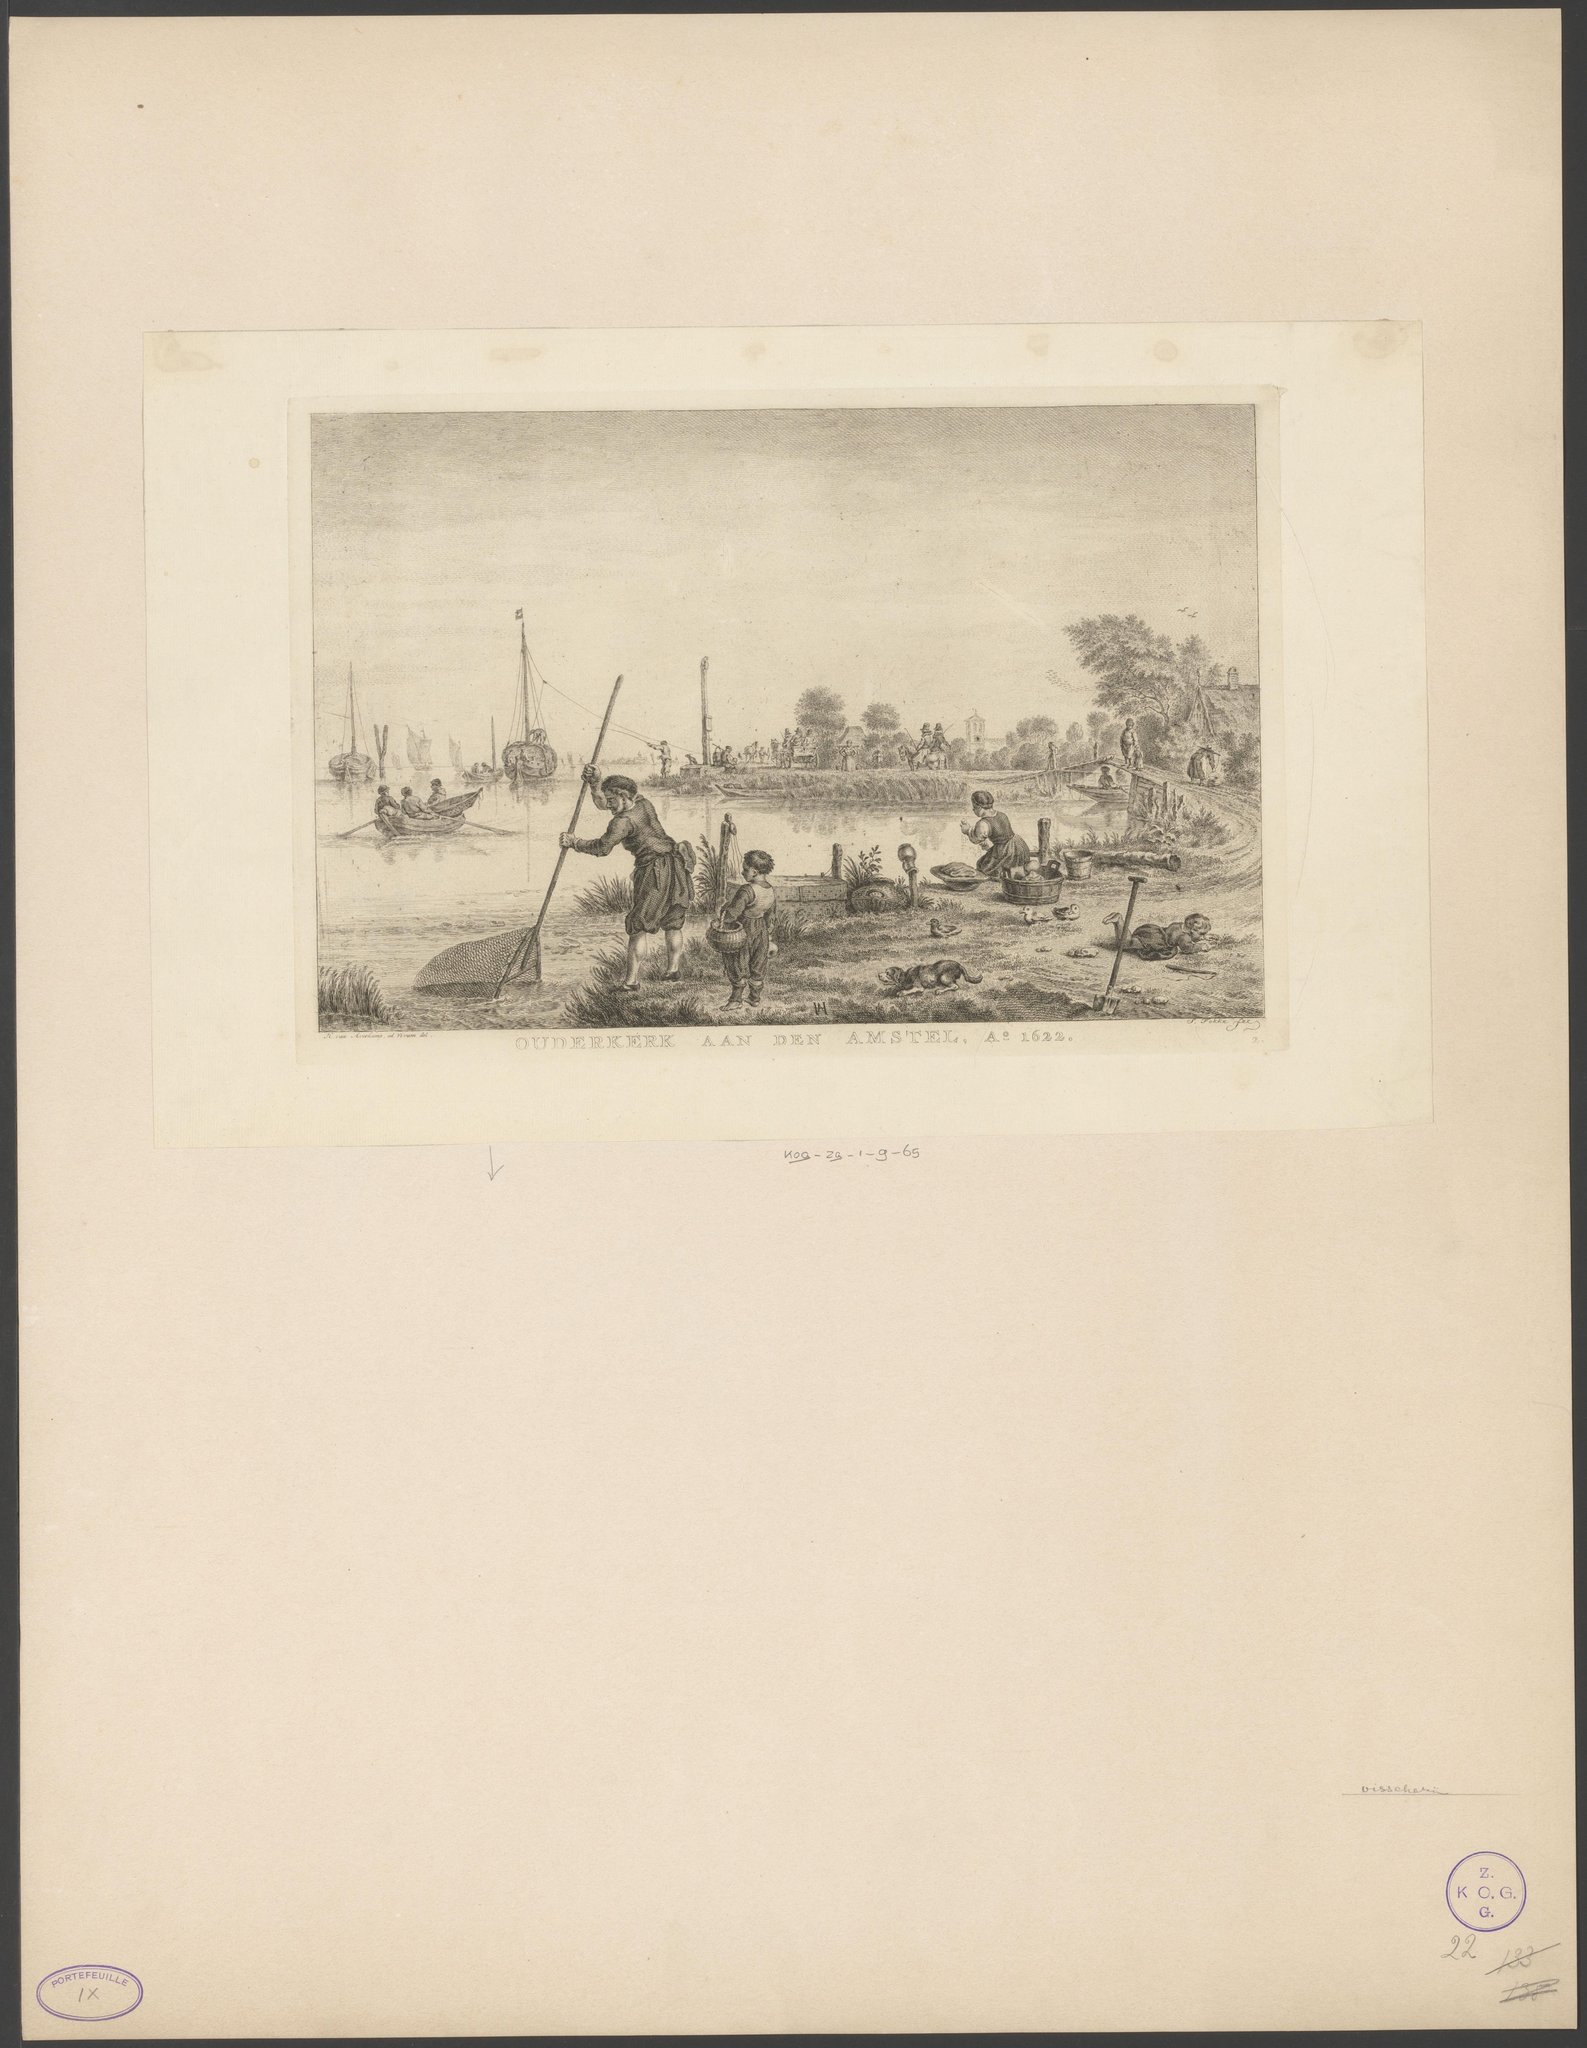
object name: print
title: Figuren op de oever bij Ouderkerk aan de Amstel, 1622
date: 1722-1784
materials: paper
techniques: etching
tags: river bank, rowing-boat, canoe, etc., open-air recreation, fisherman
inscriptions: collector's mark: Lugt 1641, stamp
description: Figuren op de oever bij Ouderkerk aan de Amstel. Een jongetje kijkt toe hoe een man met een schepnet vis vangt. De vrouw verderop doet de was en heeft haar kind in de wastobbe achter haar gezet. In het gras van de oever liggen eenden, een hond en een spelend kind. In de verte passanten te voet en te paard. Op het water varen roei- en zeilschepen. Rechtsonder genummerd: 2. Onderwerpsrubrieken binnen de Atlas Zeden en Gewoonten: Handel, nijverheid en verkeer, Visscherij, Zee- en Riviervisscherij.